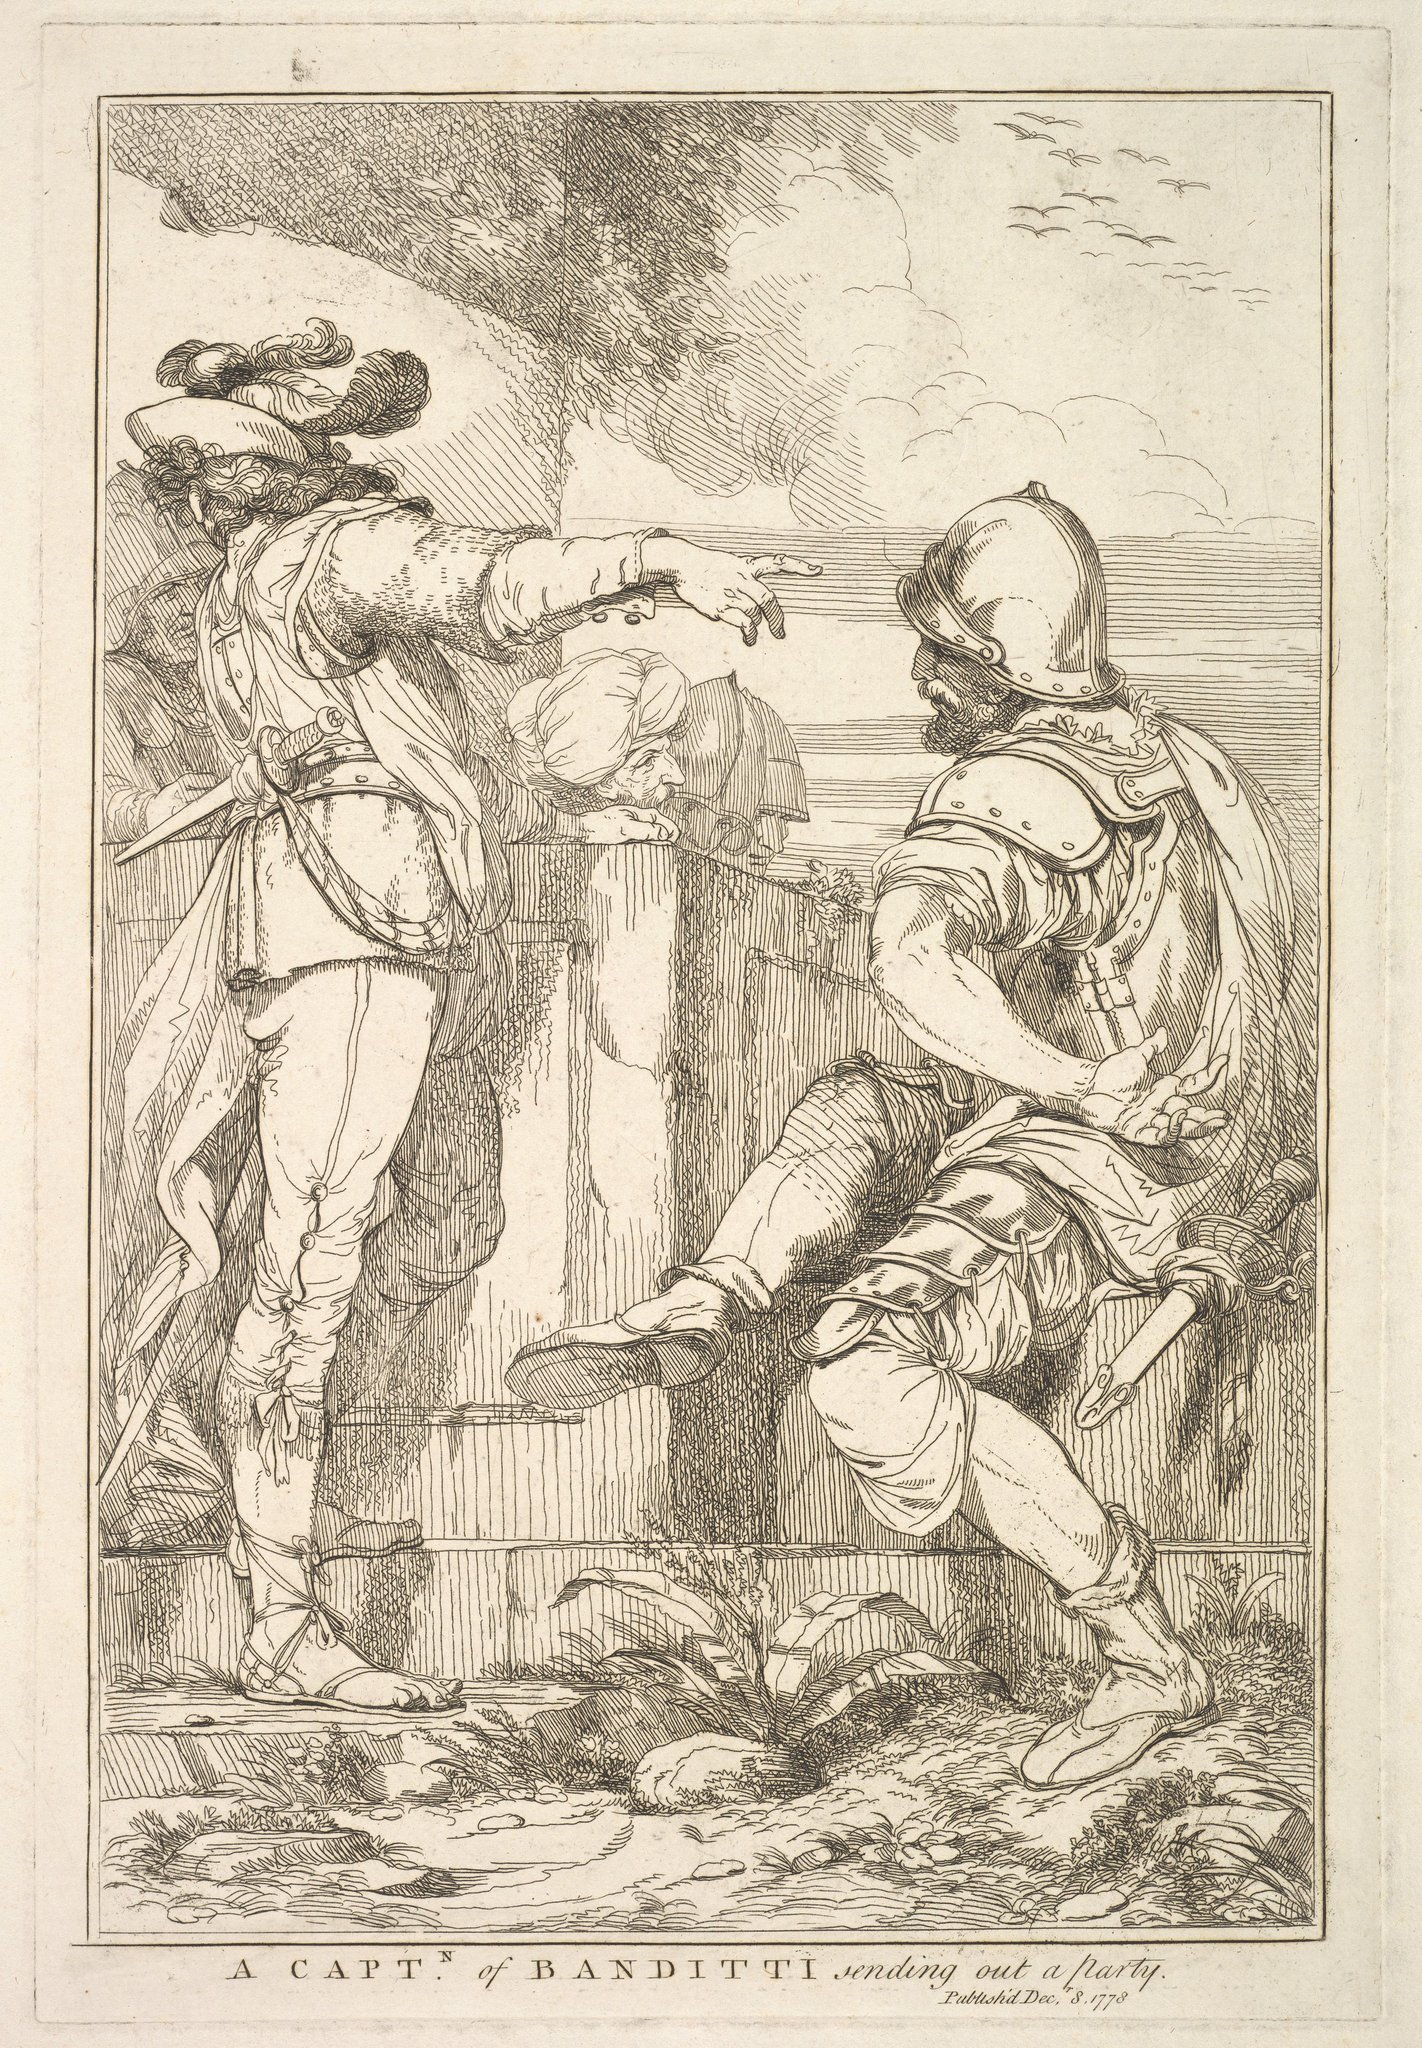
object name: print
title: A Captain of Banditti Sending Out a Party, from "Fifteen Etchings Dedicated to Sir Joshua Reynolds"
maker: john hamilton mortimer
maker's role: artist and publisher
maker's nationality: british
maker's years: 1740-1779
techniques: etching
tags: weapons,men